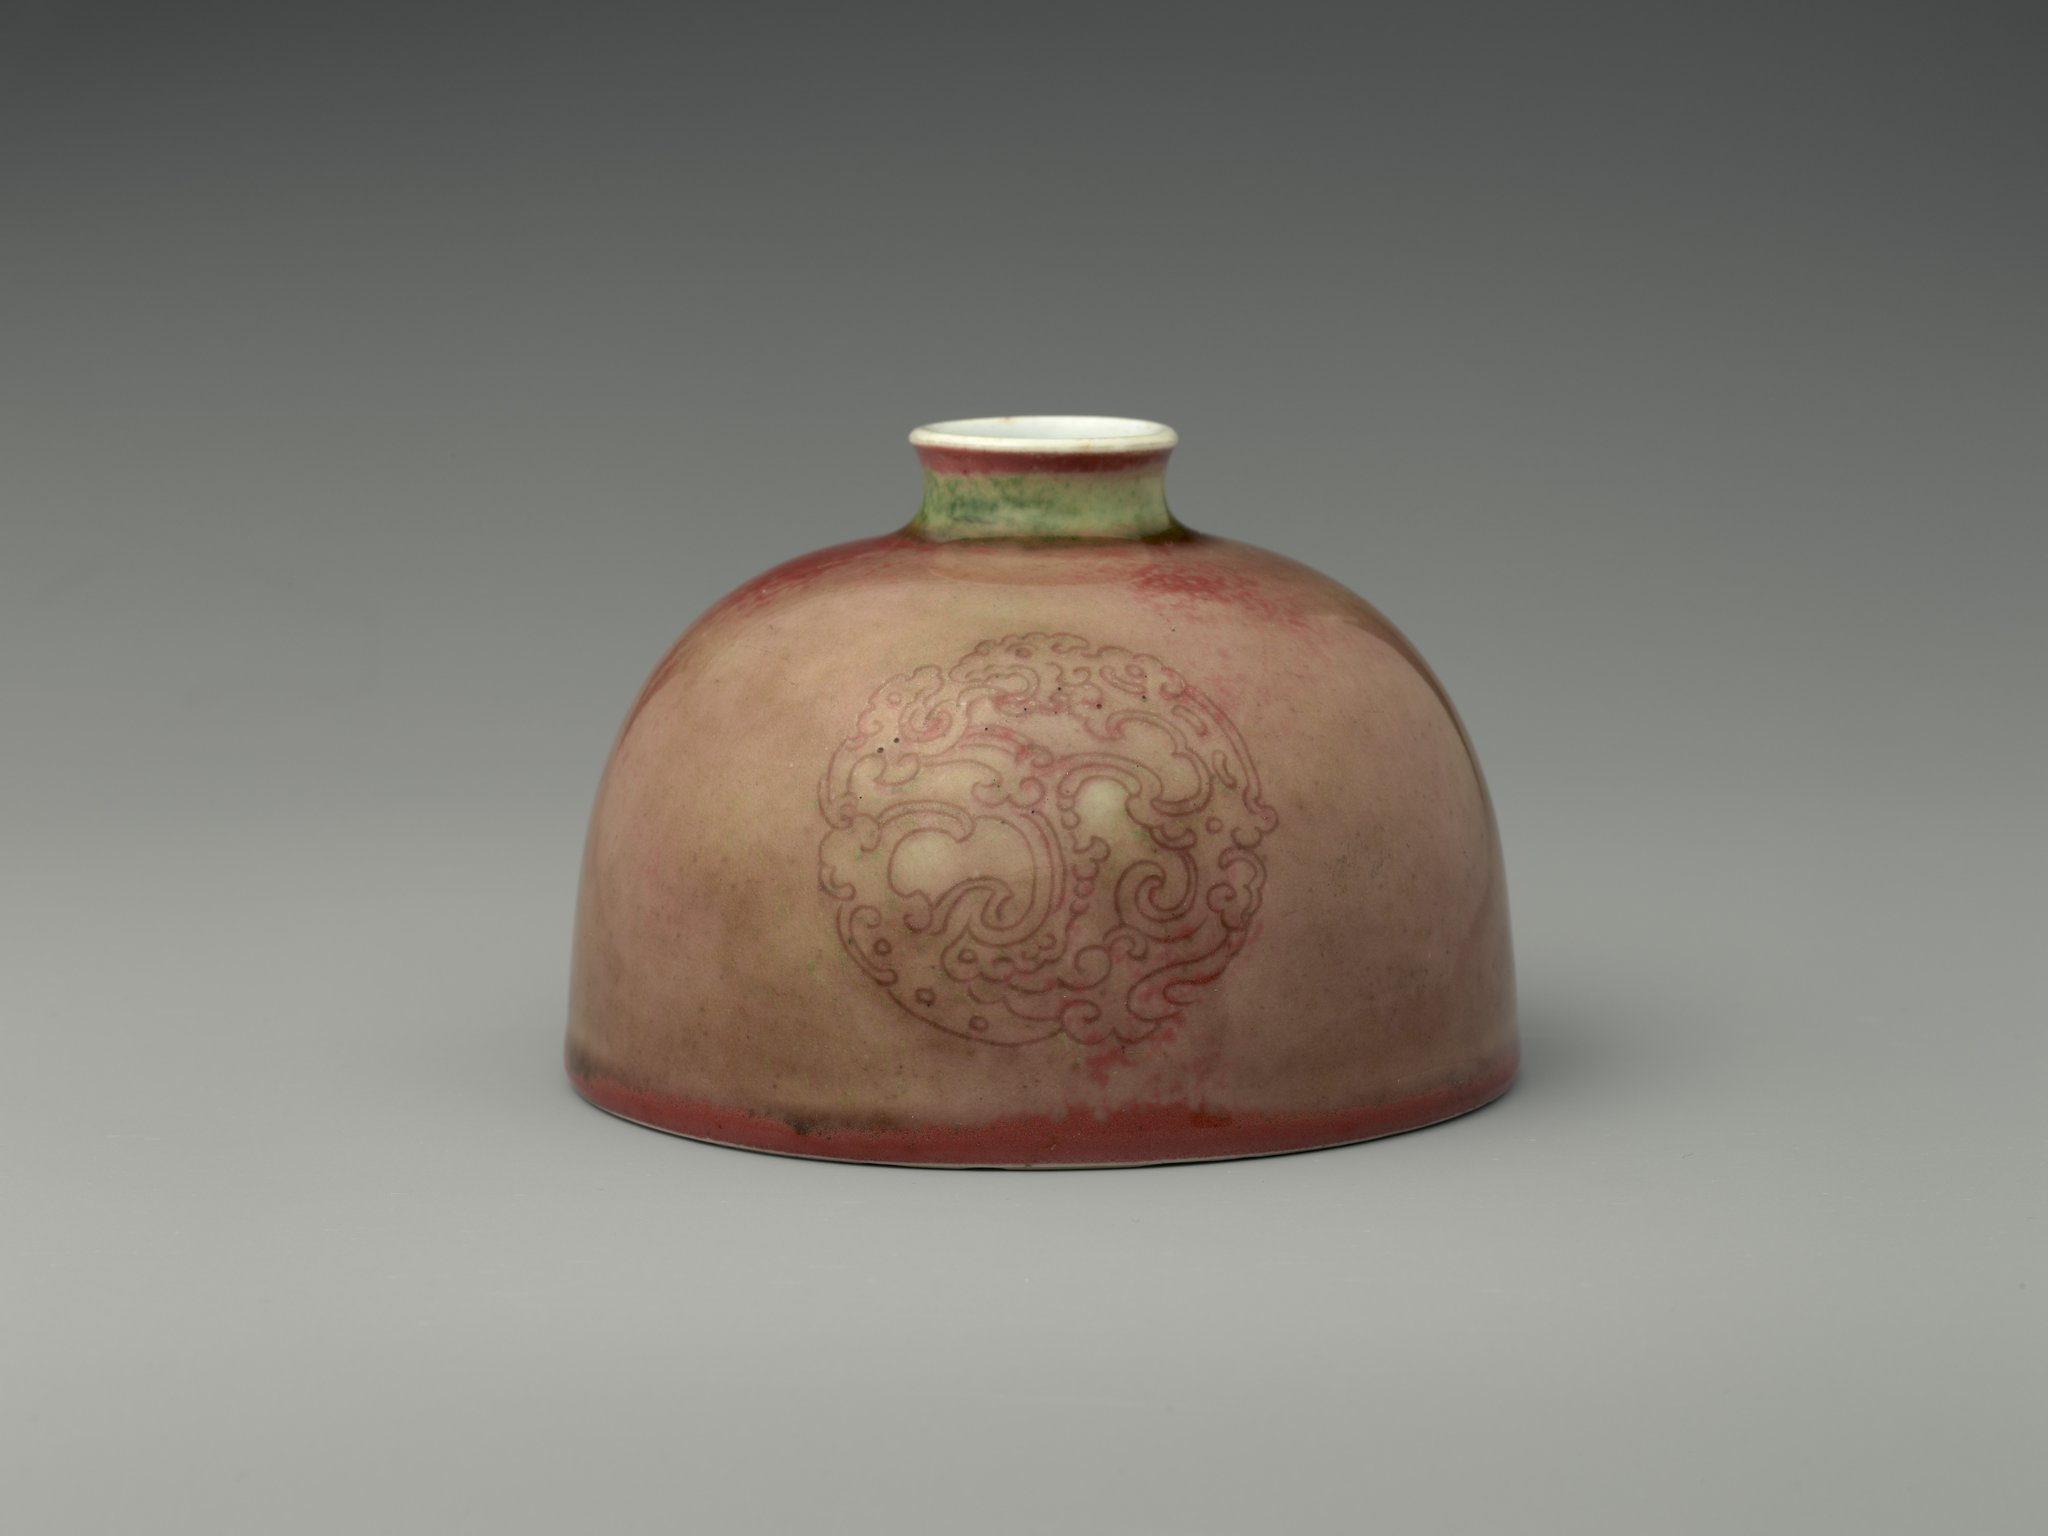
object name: water coupe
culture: chinese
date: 1667-1700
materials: porcelain